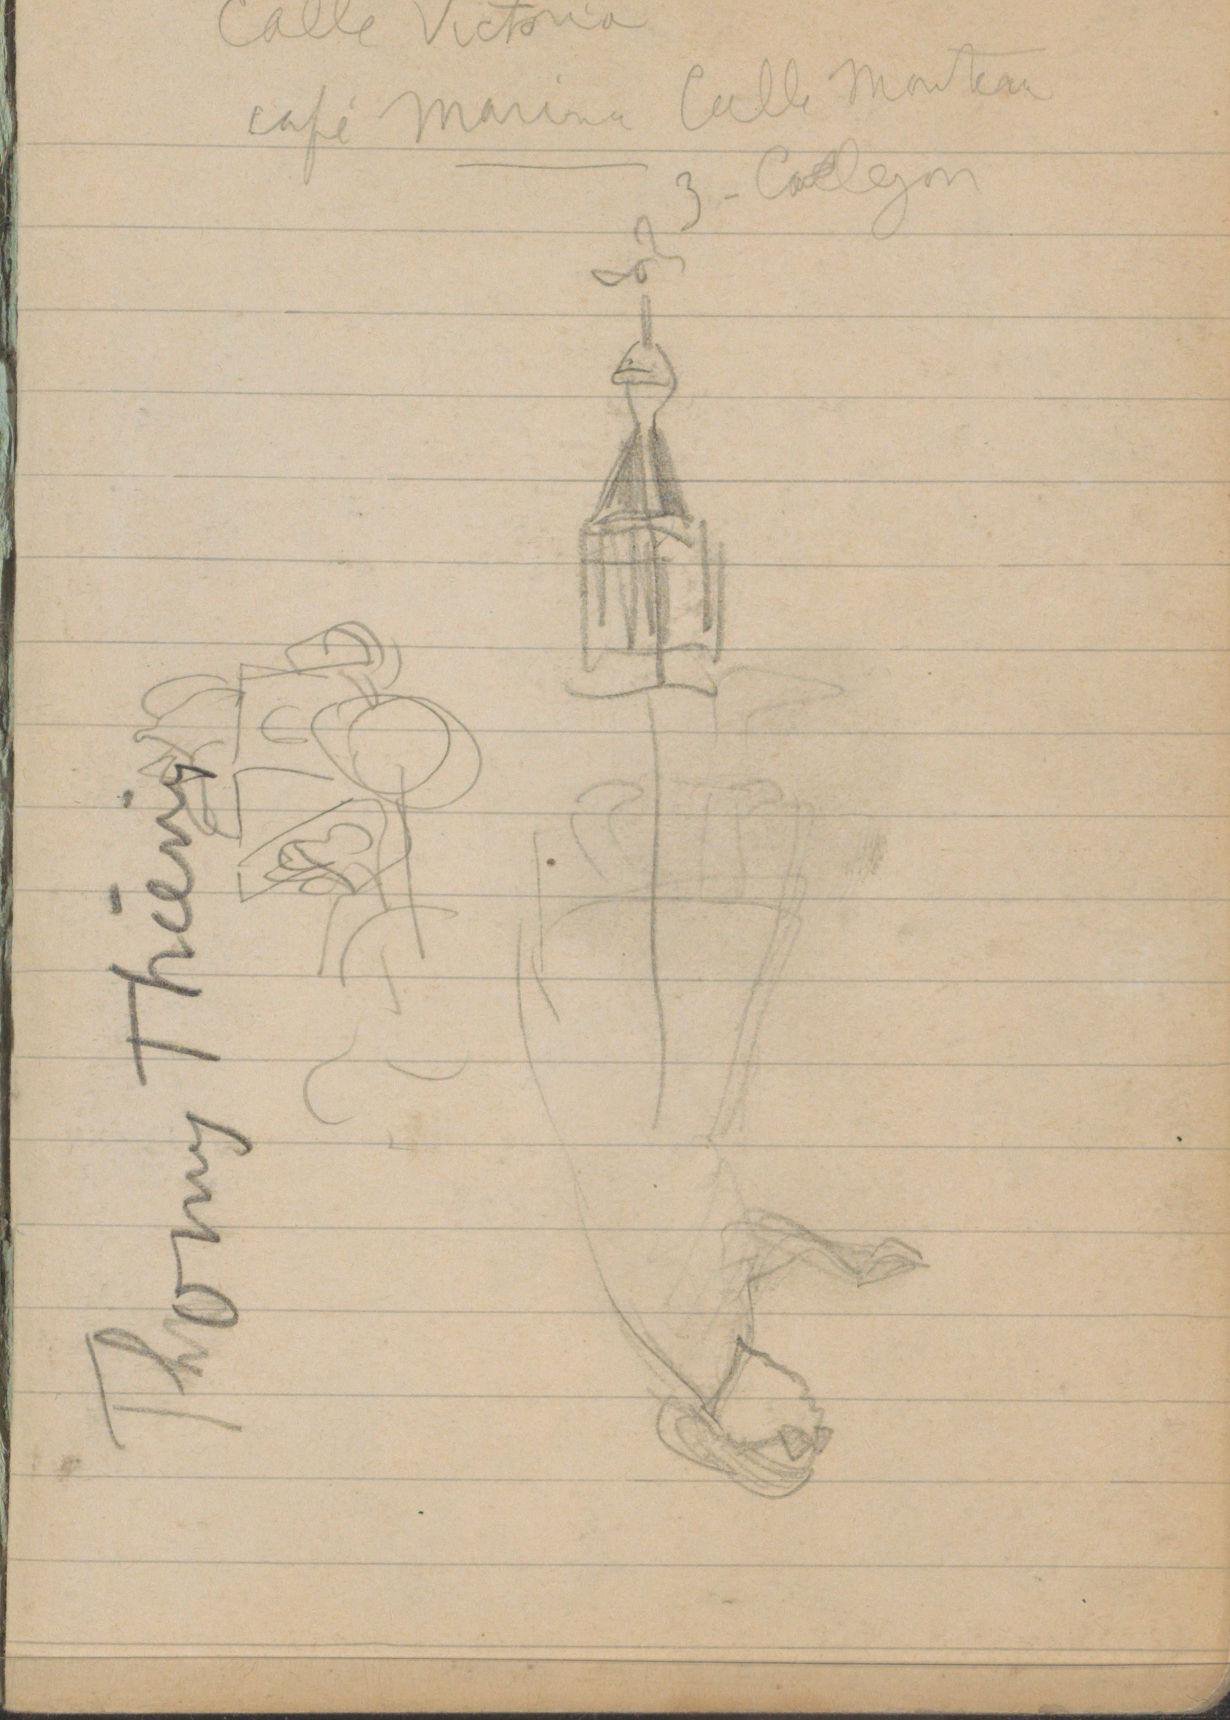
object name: sketchbook leaf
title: Bedelende vrouw, torenspits en kar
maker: marius bauer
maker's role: draughtsman, print maker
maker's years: 1867-1932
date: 1902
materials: pencil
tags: spire (of tower on house or building), beggar, (farm) wagon, freight wagon, cart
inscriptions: annotation: ‘Calle Victoria/ café Marina Calle Manteau/ 3. Ca[...]m/ Thomy Thienij’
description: Pagina 1 uit een schetsboek met 50 bladen.